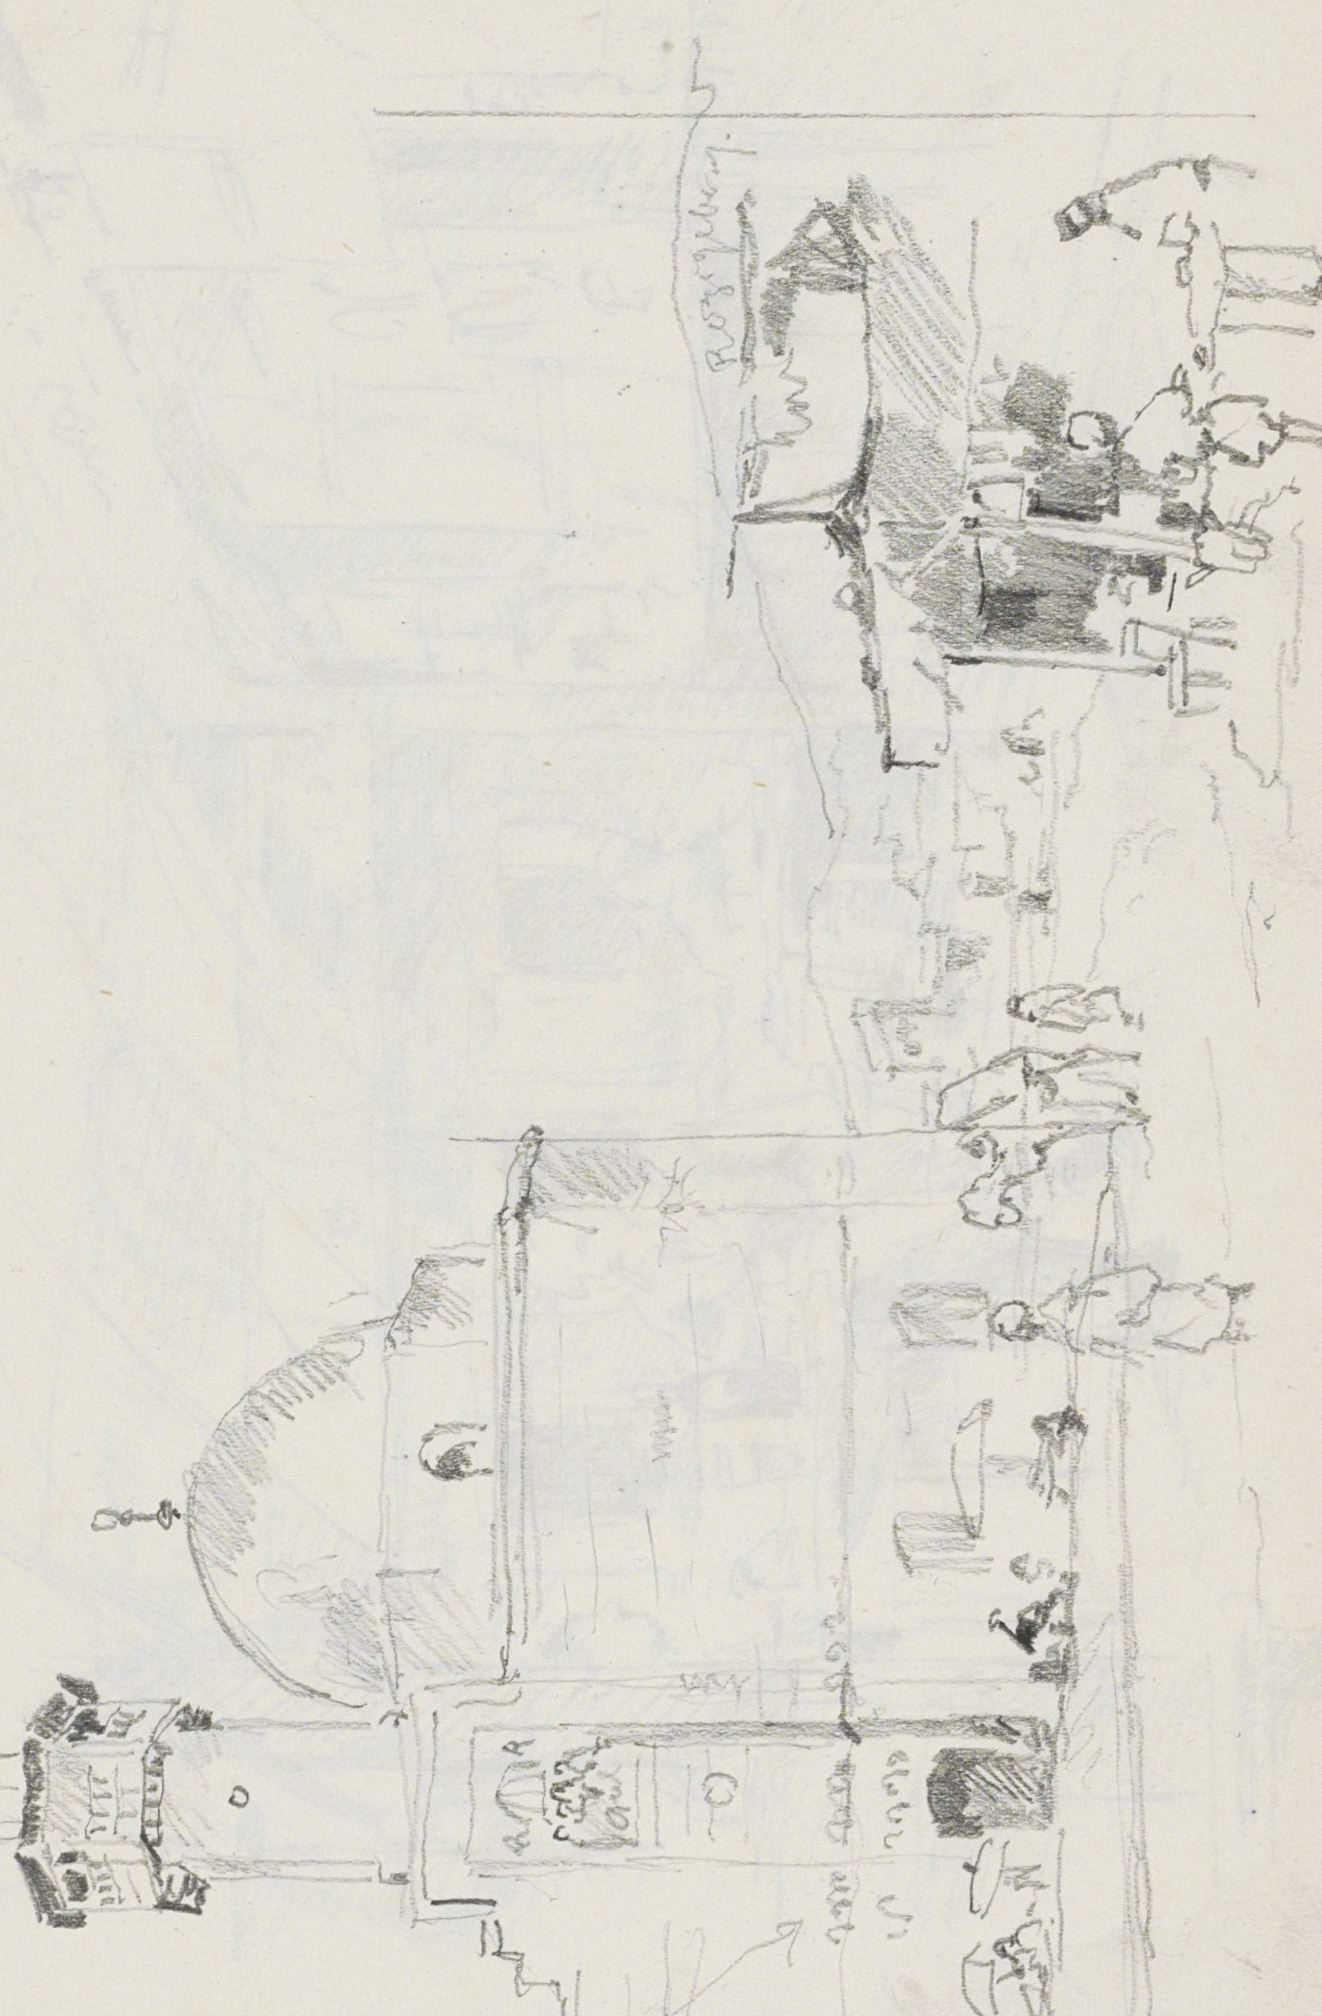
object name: sketchbook leaf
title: Figuren op een straat met een moskee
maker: cornelis vreedenburgh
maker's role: draughtsman, print maker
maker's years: 1880-1946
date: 1936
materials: paper, pencil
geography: maghreb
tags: temple, shrine ~ islam, mohammedanism, street (+ city(-scape) with figures, staffage)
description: Op de straat loopt ook een dromedaris. Blad 46 recto uit een schetsboek met 73 bladen.